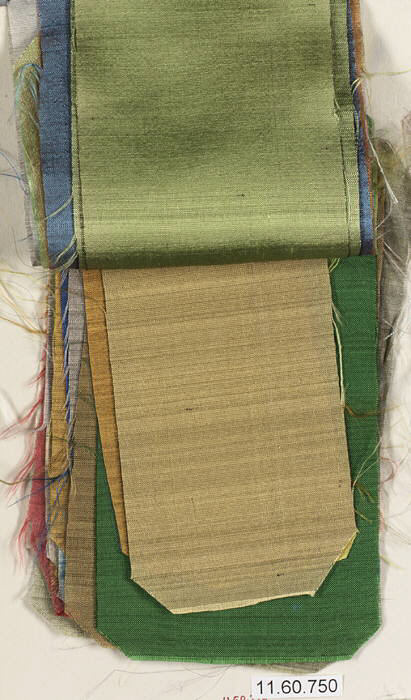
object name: sample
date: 1801-1833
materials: silk